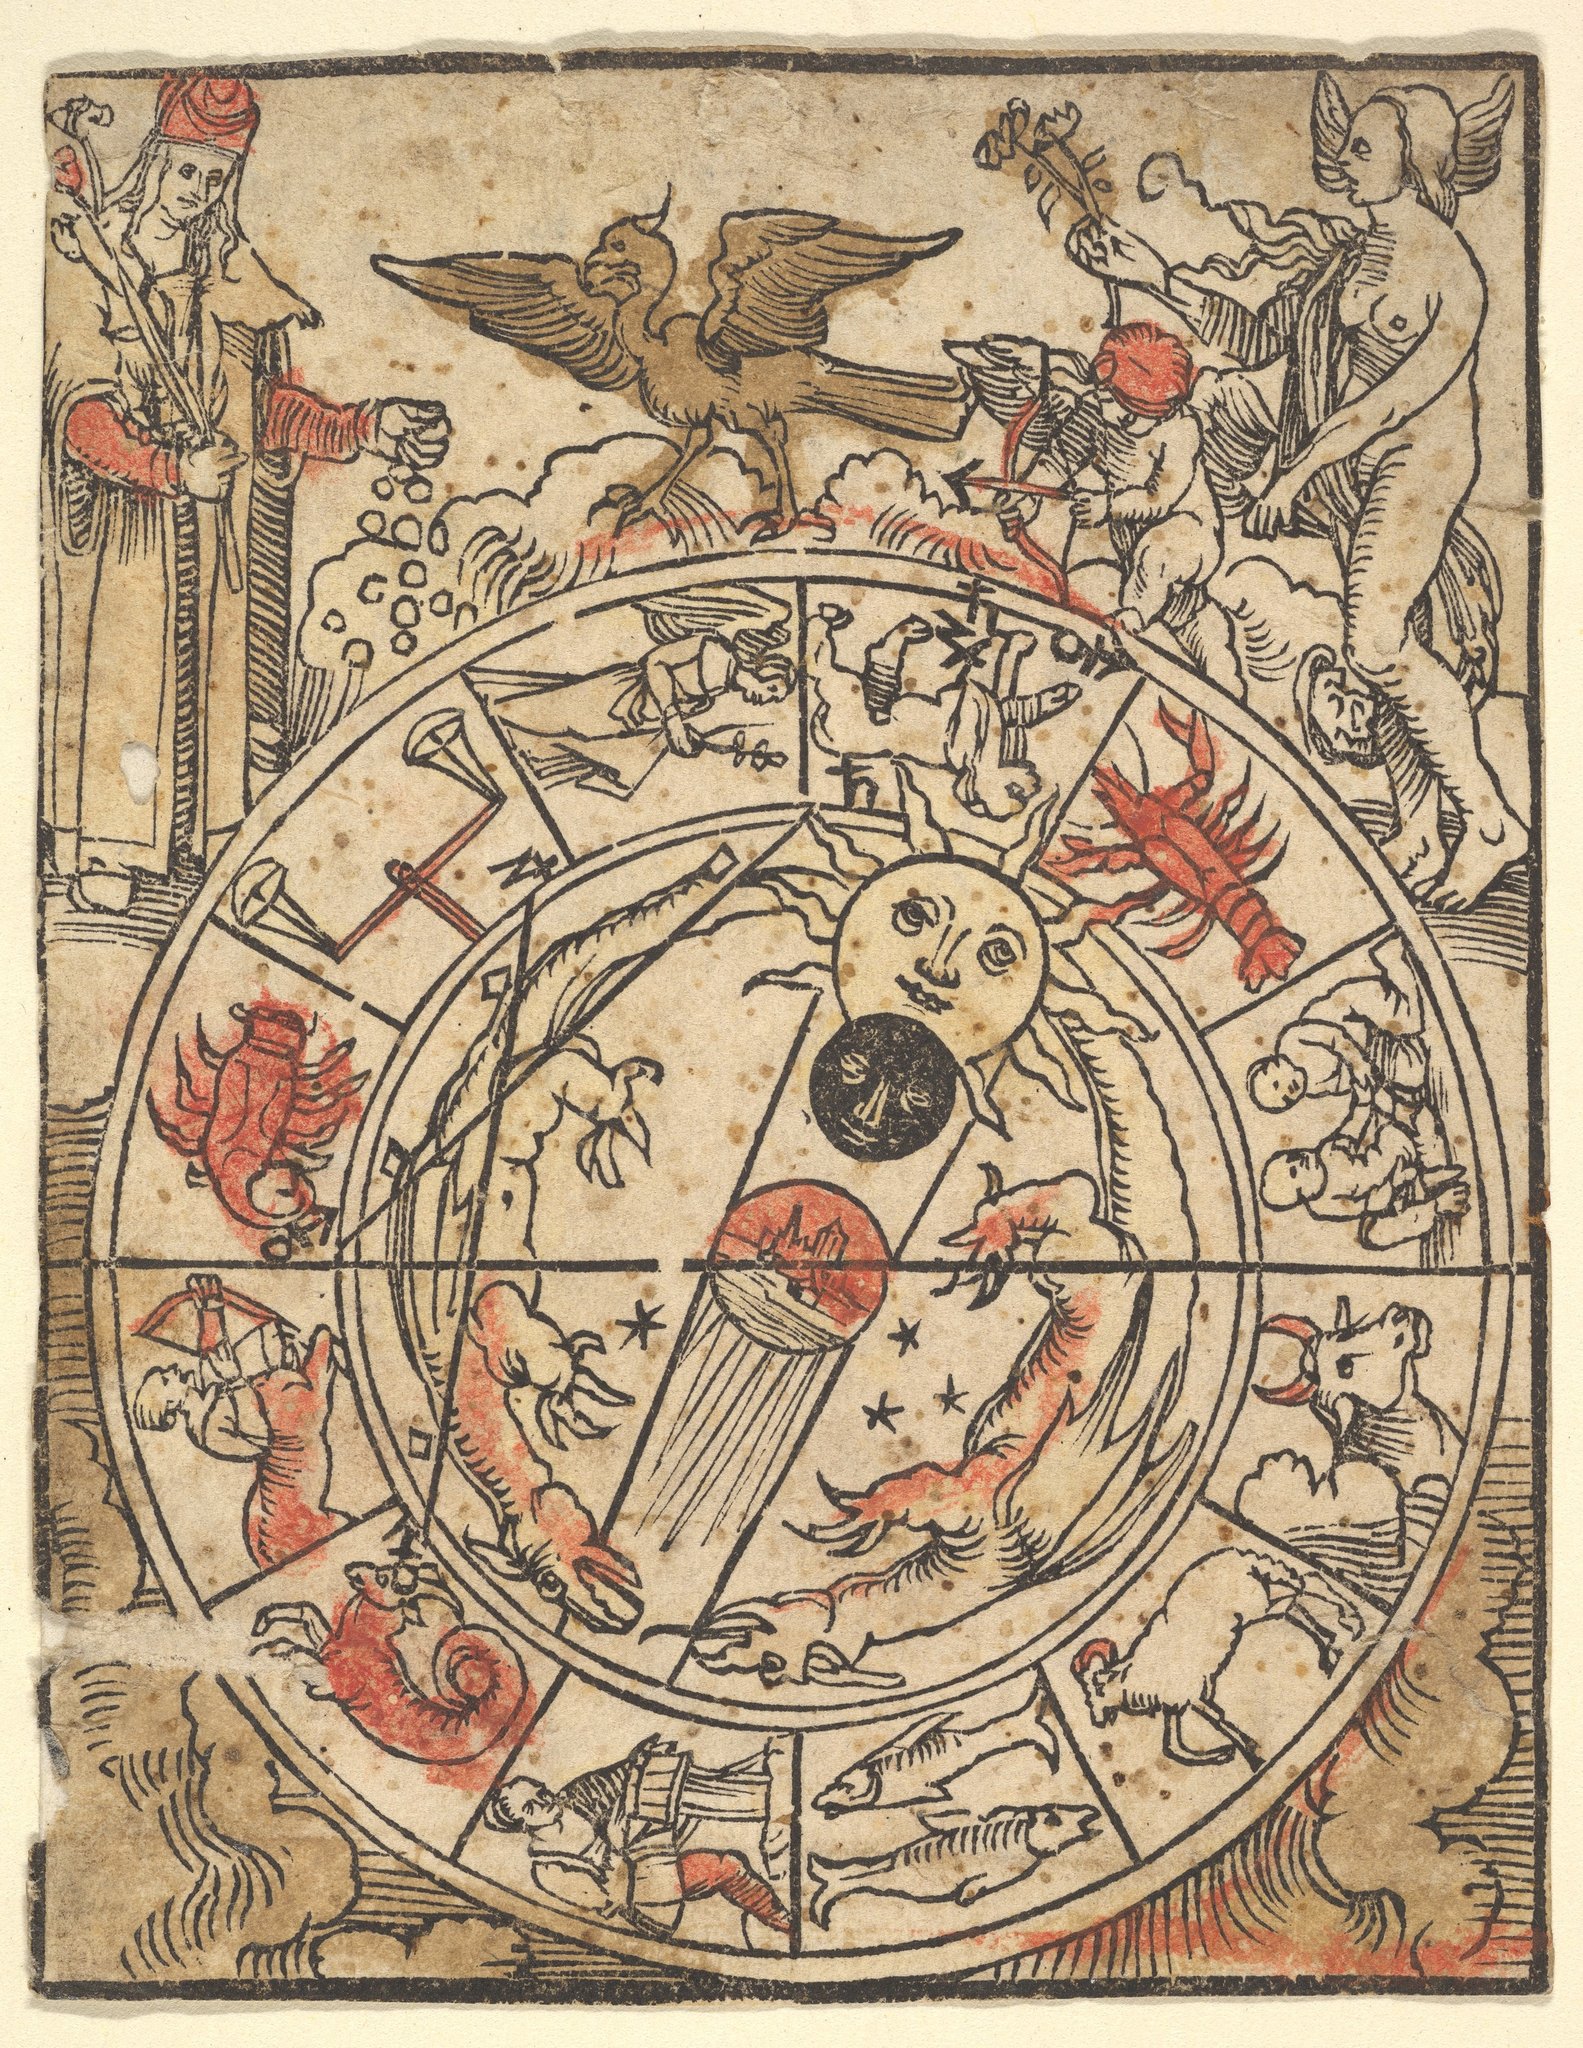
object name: print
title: Chart of the Signs of the Zodiac with Venus, Cupid, and a Bishop Saint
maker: hans baldung (called hans baldung grien)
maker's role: former attribution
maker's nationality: german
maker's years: 1484-1545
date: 1501-1550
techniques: hand coloring, woodcut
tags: cupid,venus,angels,saints,zodiac